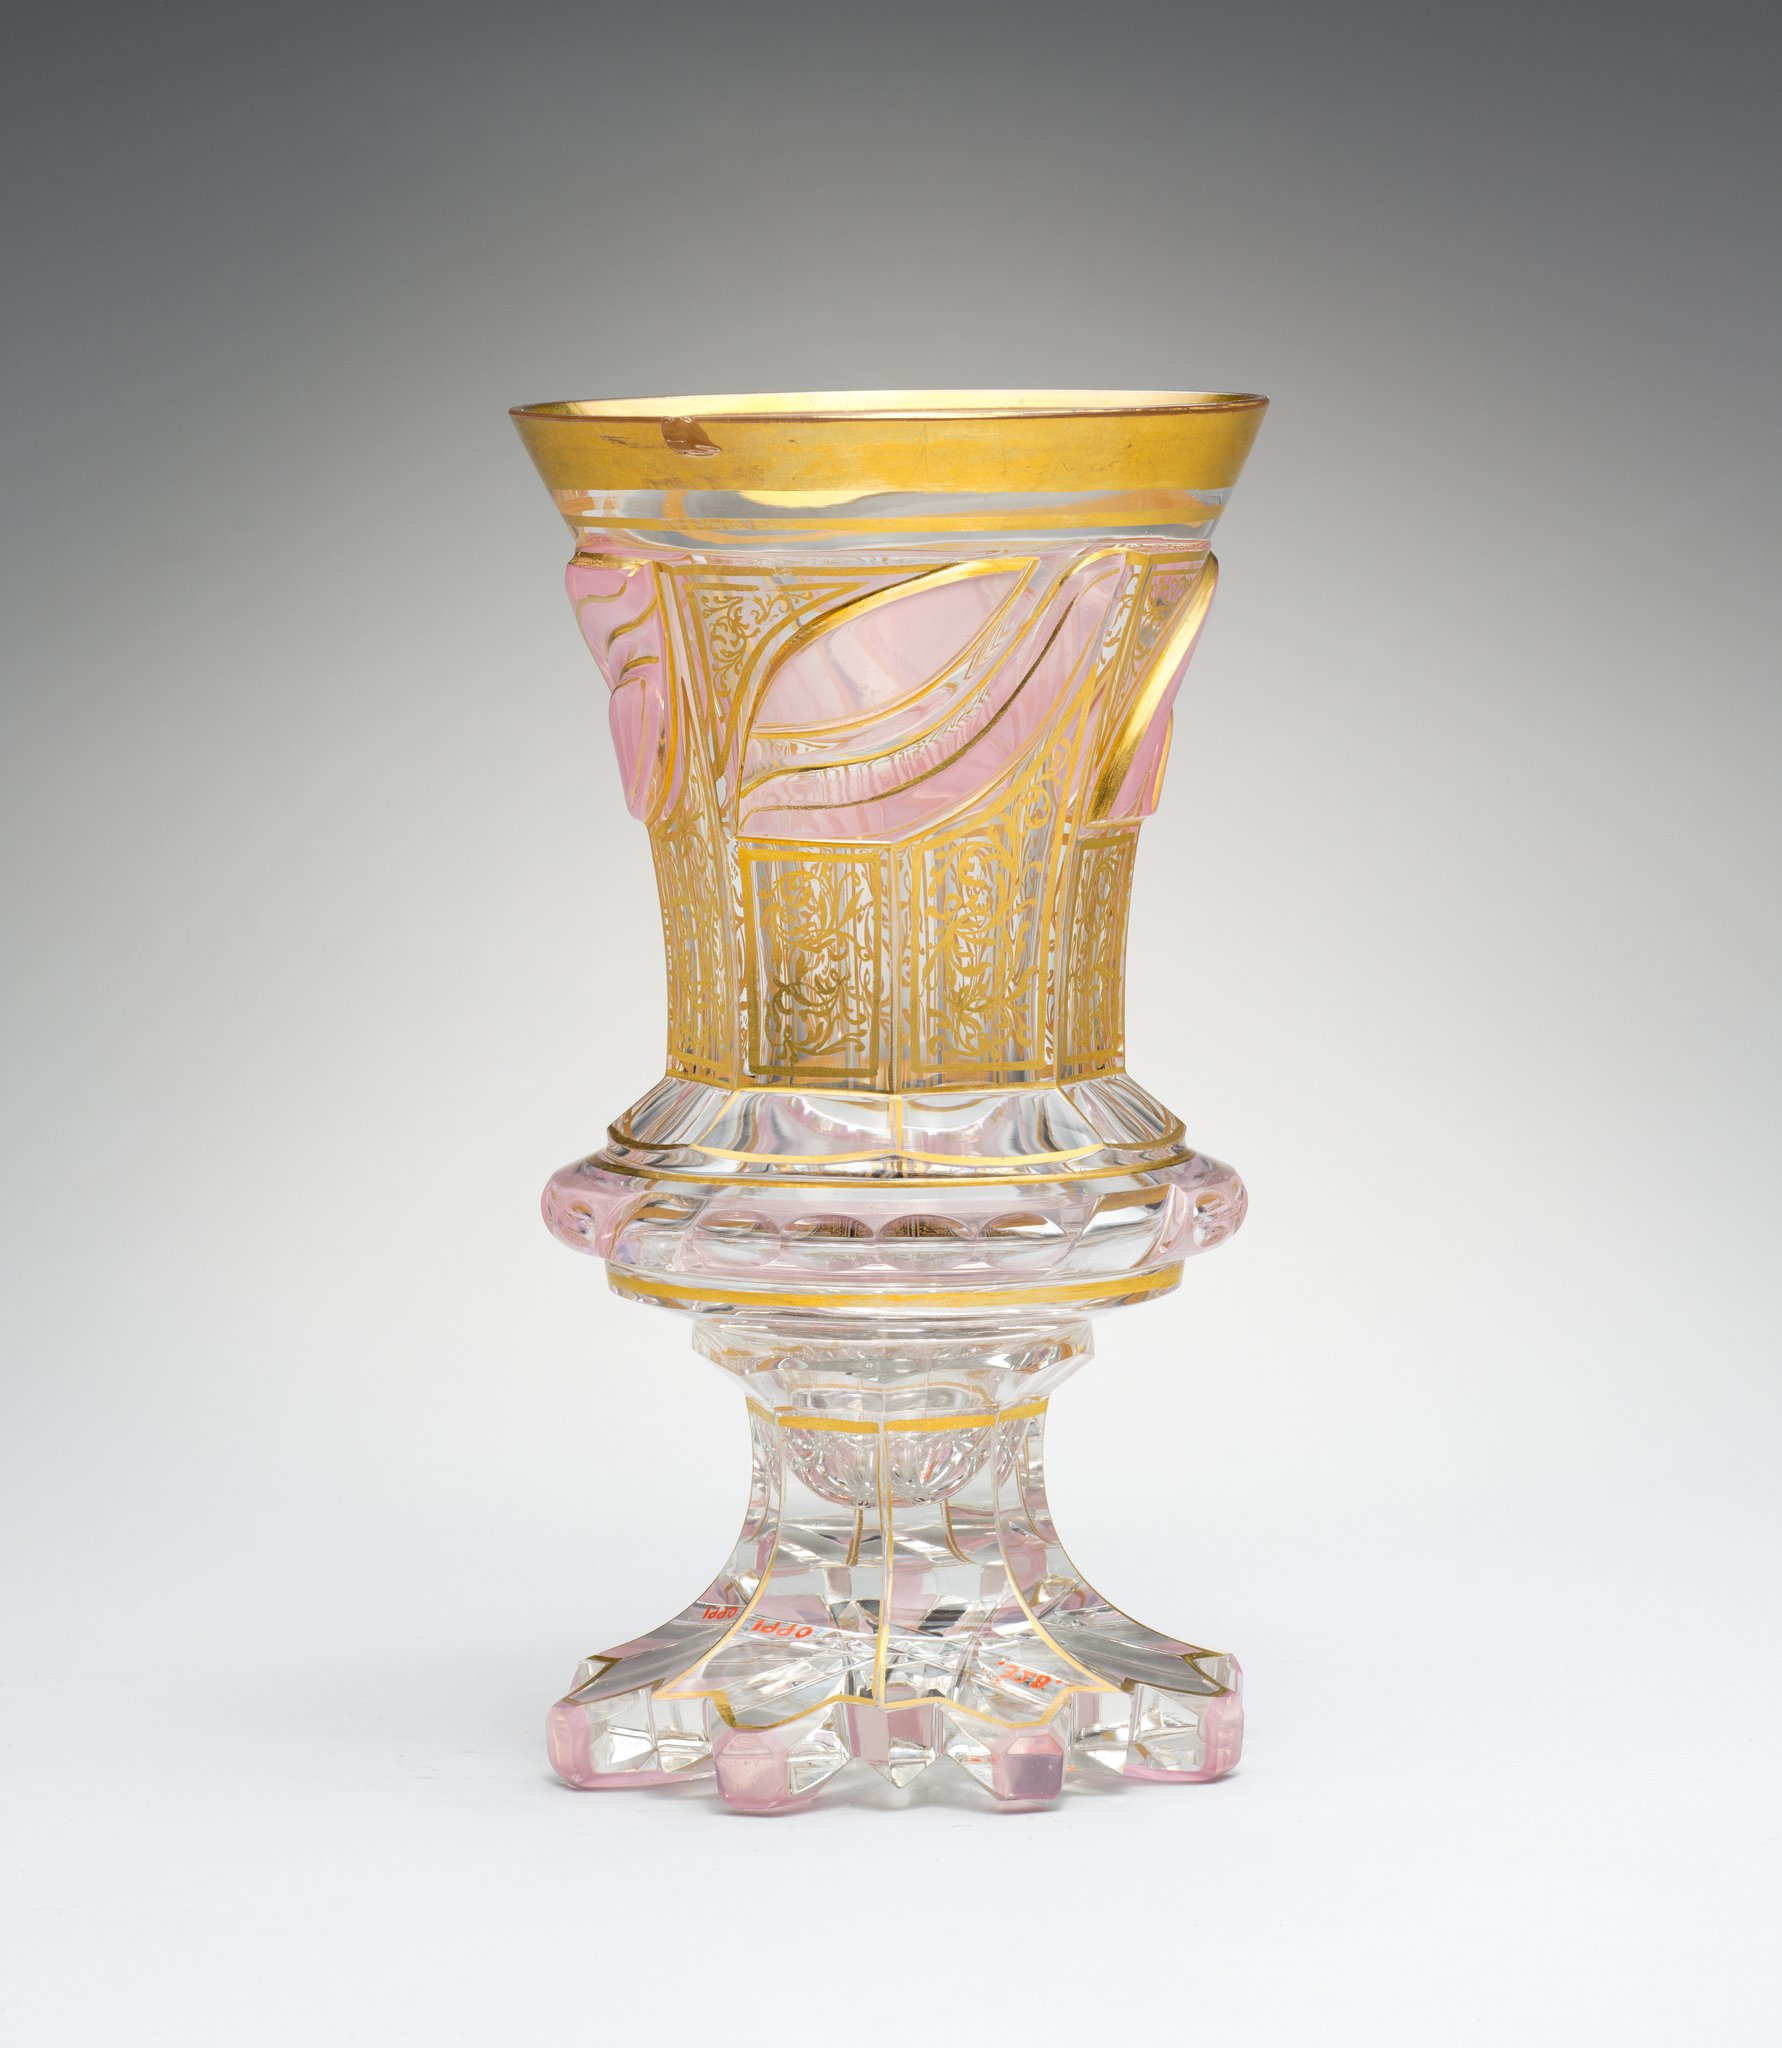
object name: goblet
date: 1835-1845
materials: glass